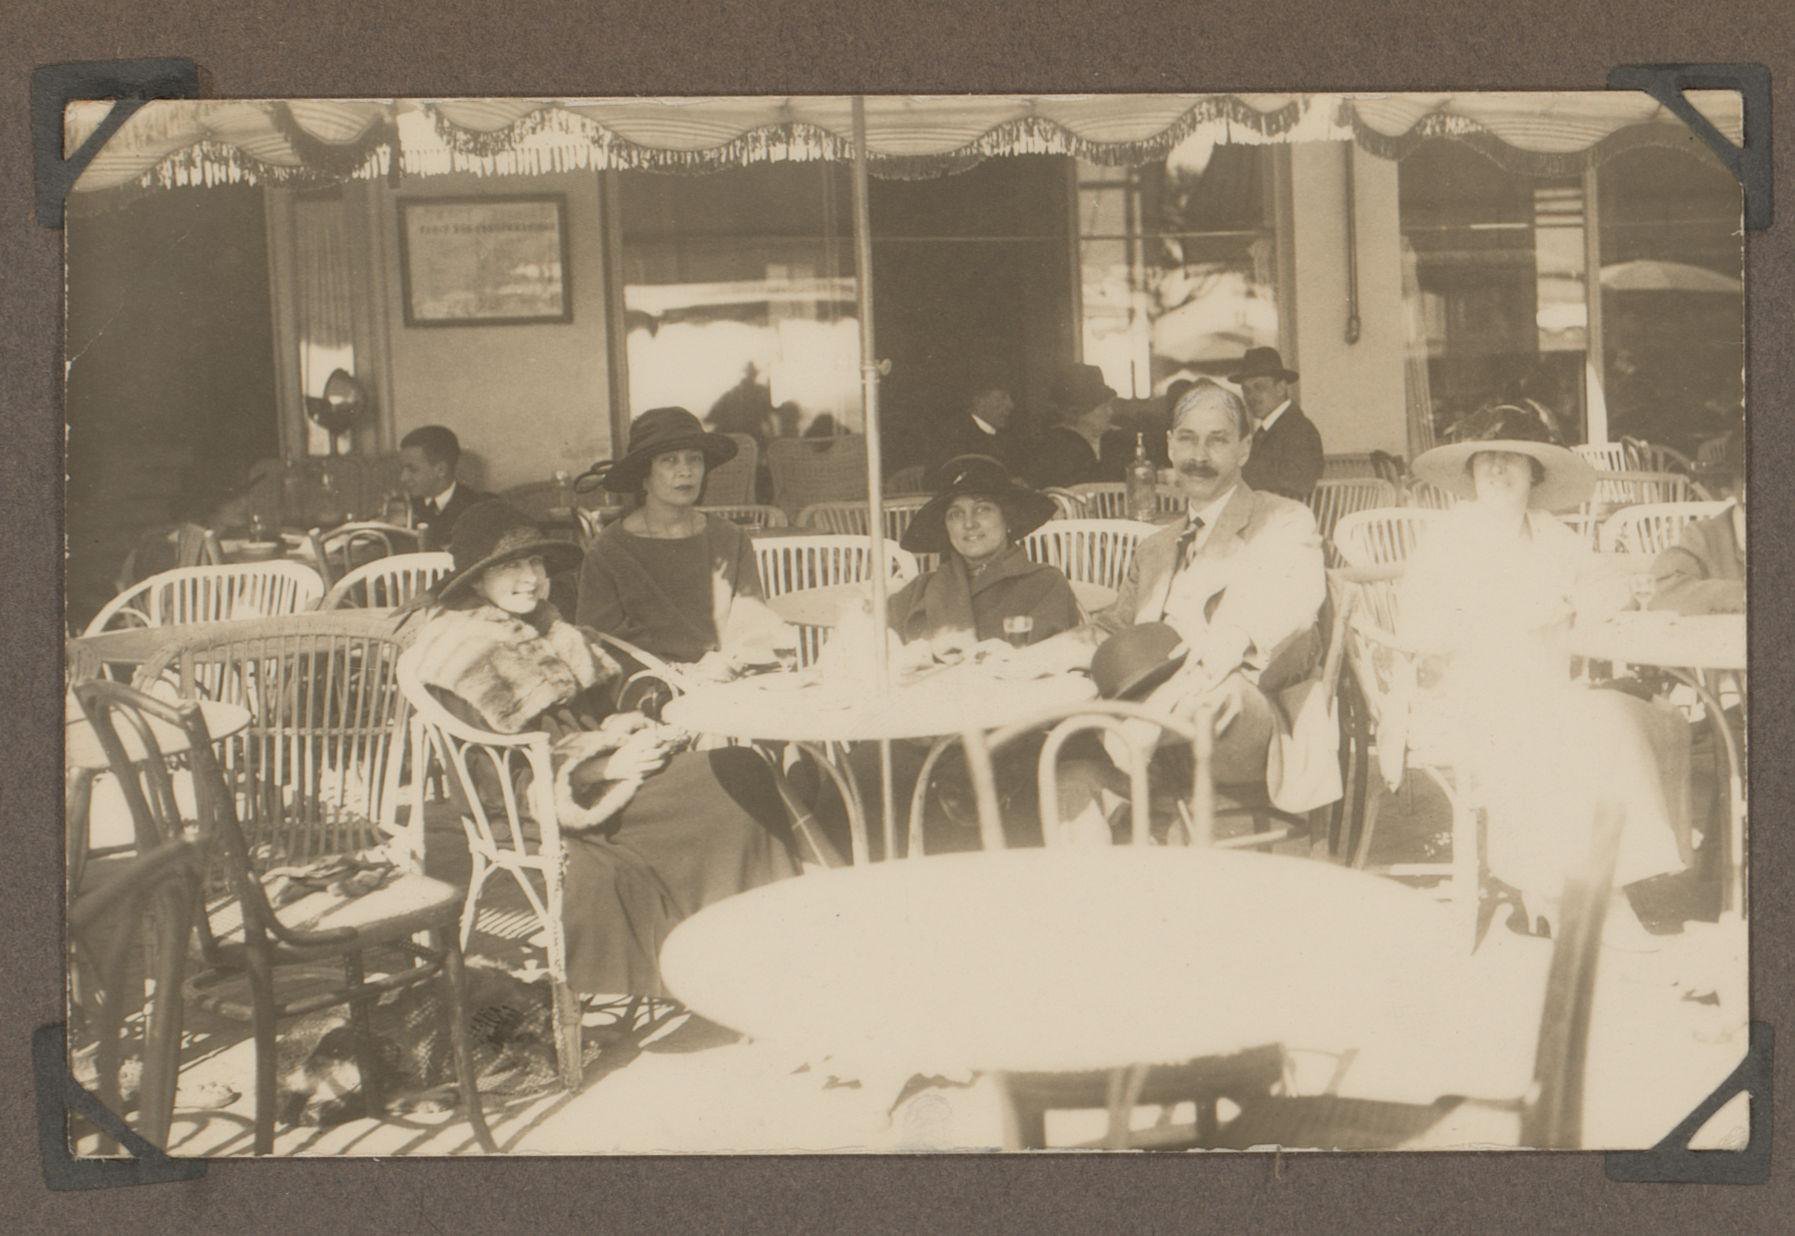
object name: photograph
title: Henriëtte Wassink en Meinard Dorus Mijer met twee anderen aan tafel op een terras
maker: Anonymous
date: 1930-1935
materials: paper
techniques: gelatin silver print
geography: netherlands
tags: batavia, the hague, henriëtte wassink, engineer, adult woman, adult man, pavement, terrace in front of inn or restaurant, netherlands